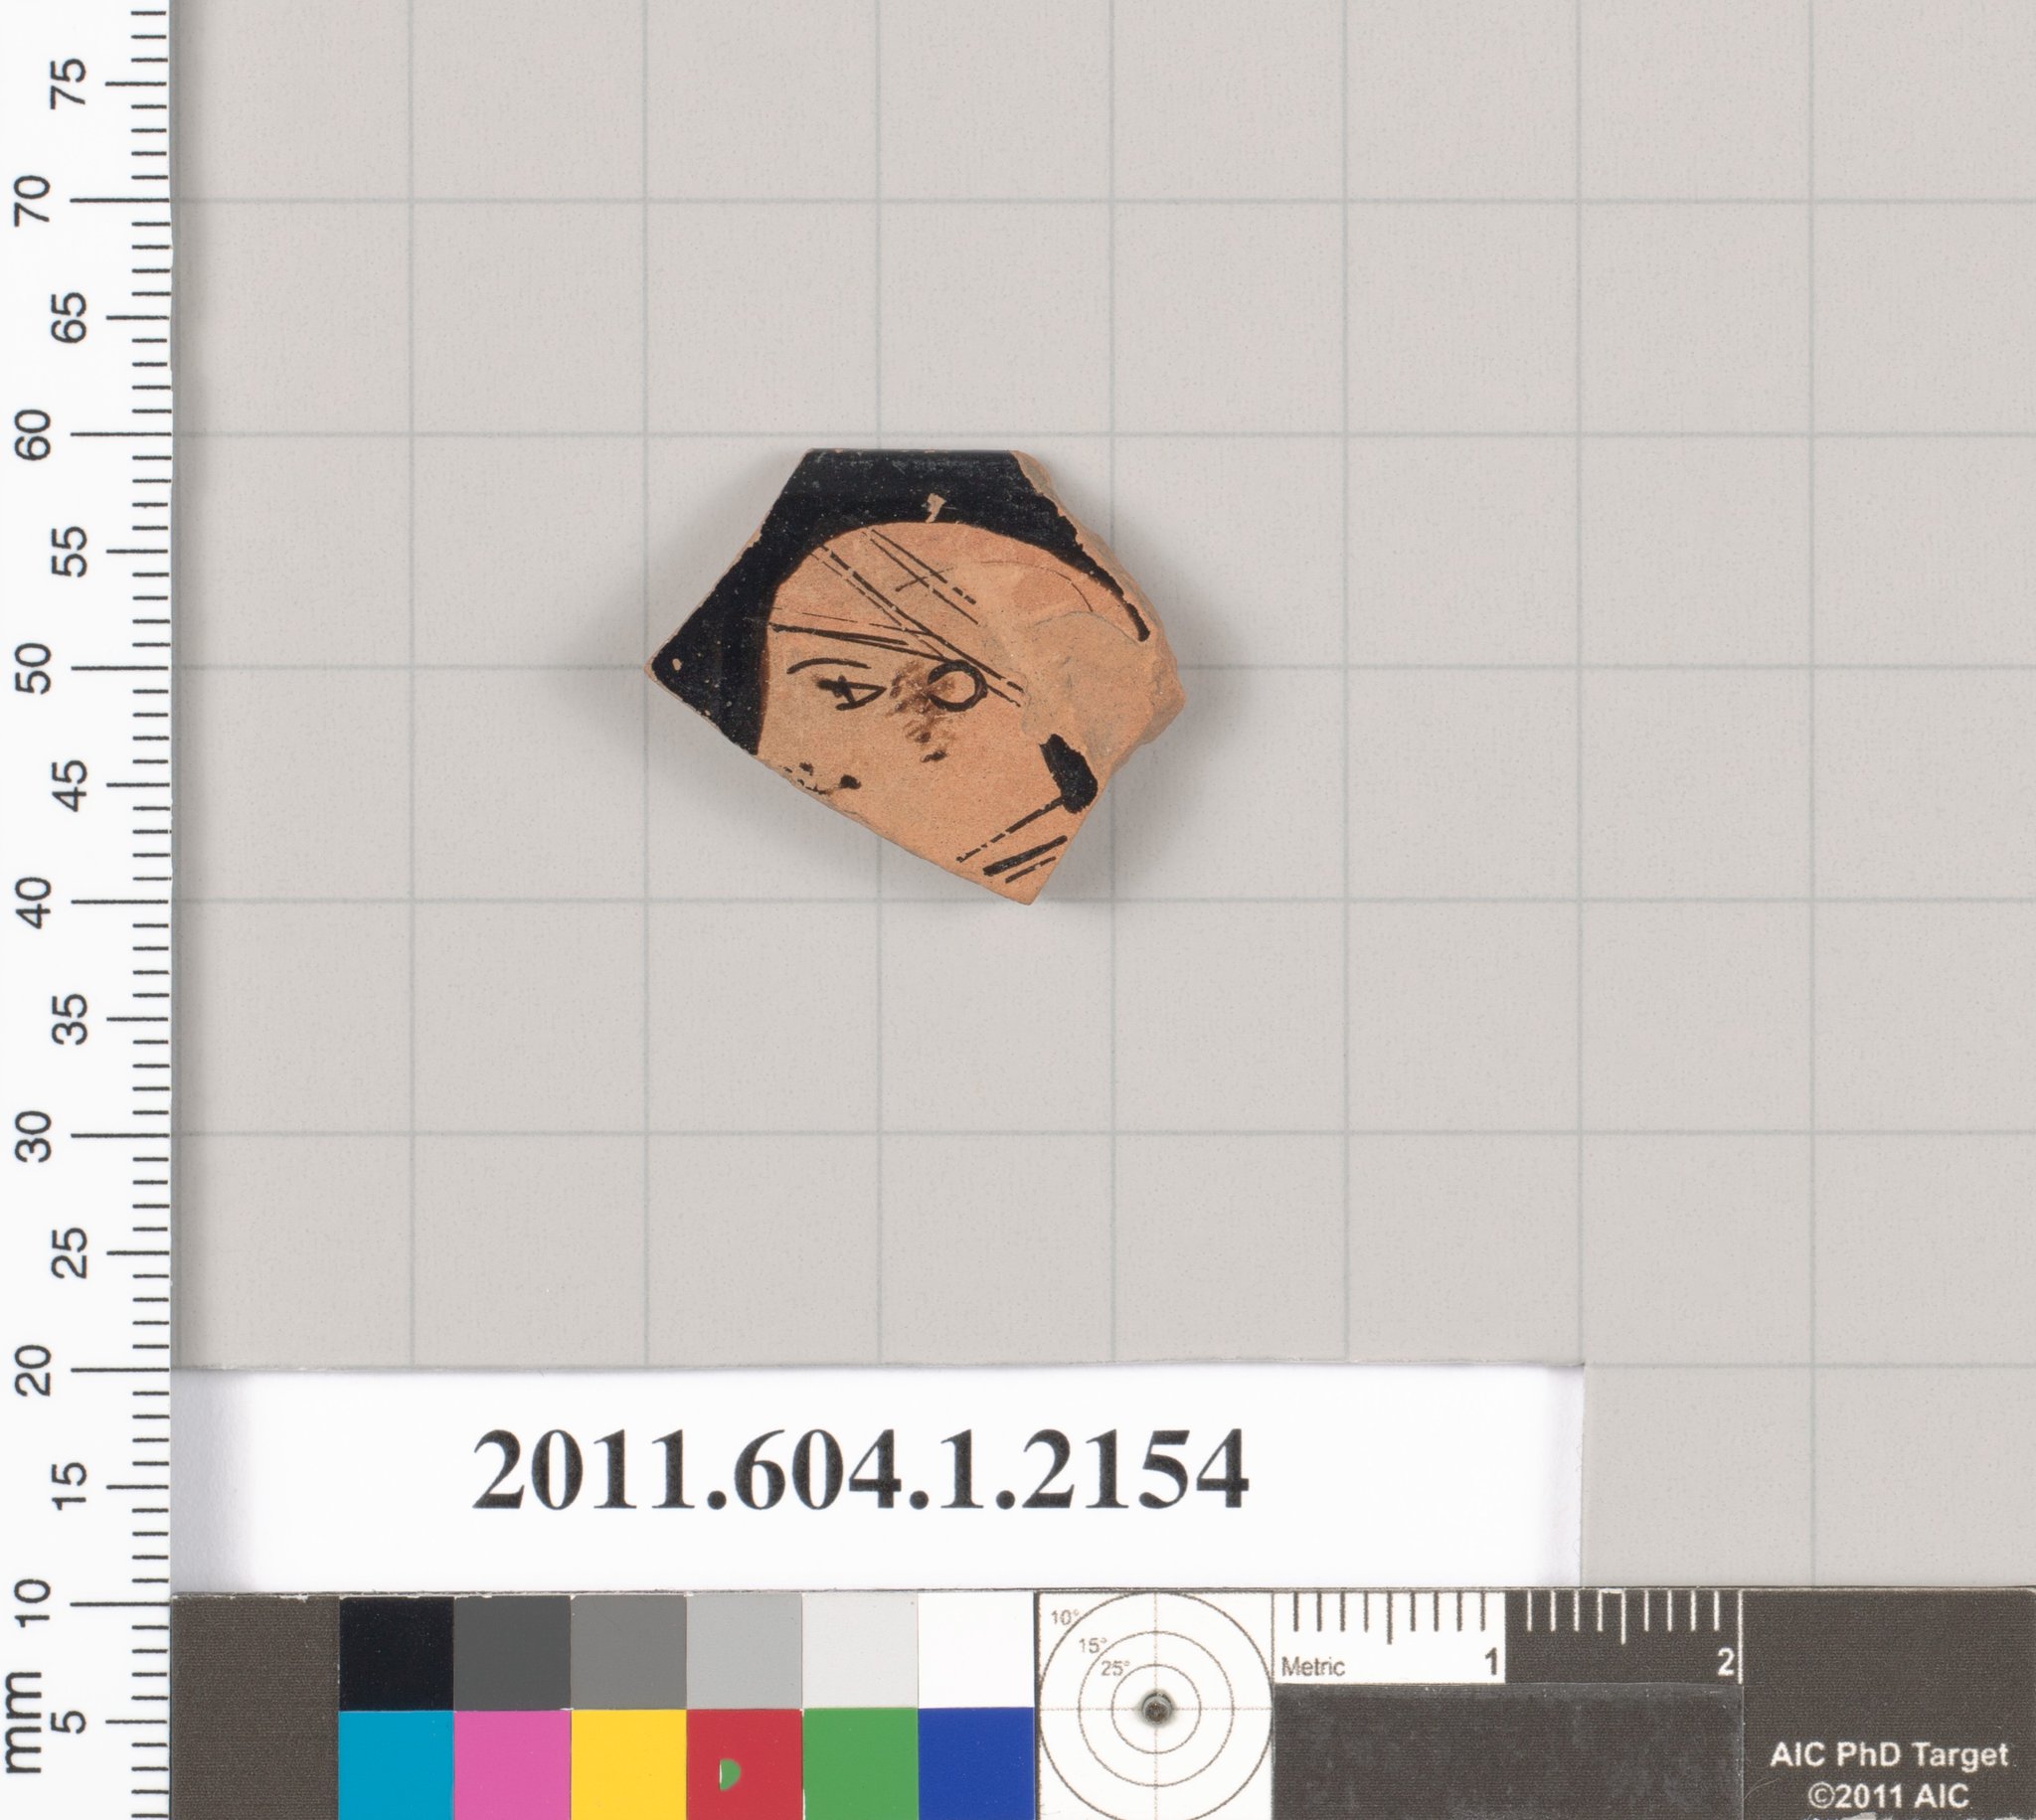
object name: kylix fragment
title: Terracotta rim fragment of a kylix (drinking cup)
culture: greek, attic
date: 467-435 BCE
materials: terracotta